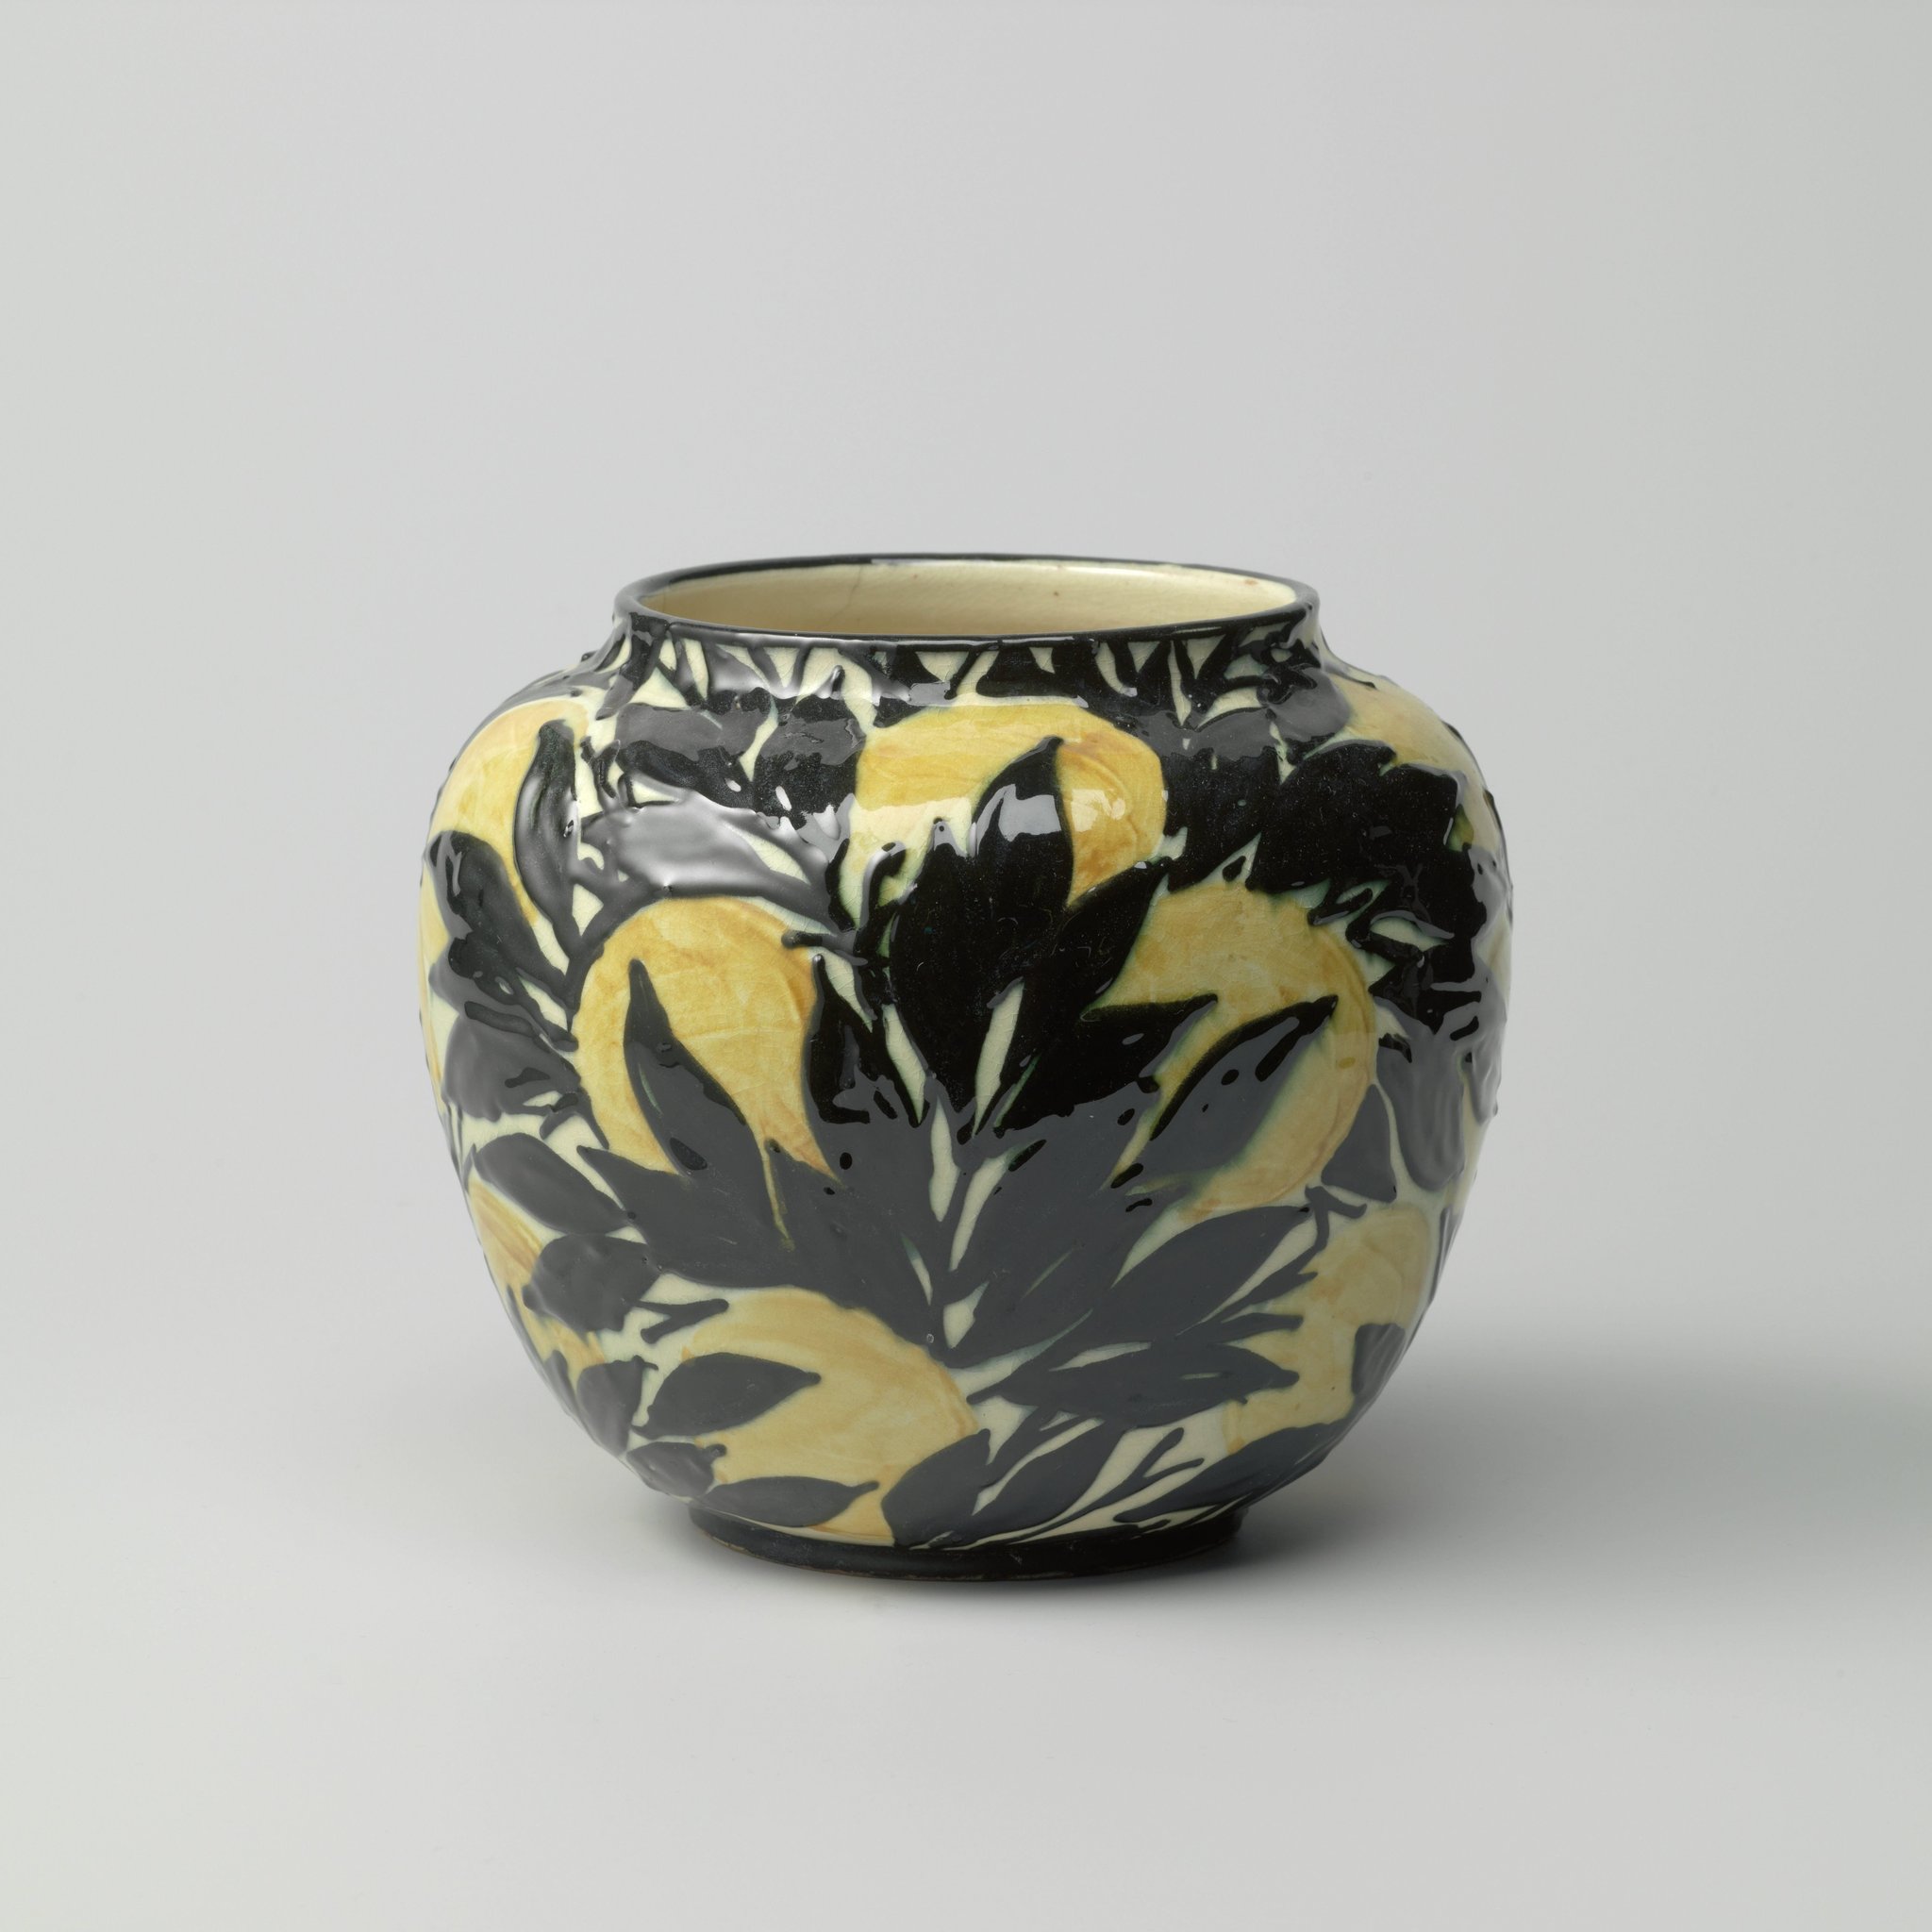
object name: pot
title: Pot van aardewerk, versierd in reliëf met gele citroenen en zwarte bladeren op een geelwitte fond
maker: max laeuger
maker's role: ceramicist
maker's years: 1864-1952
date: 1921-1925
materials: earthenware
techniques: slip technique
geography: karlsruhe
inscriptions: inscription: ‘18 03 // Prof. Läuger // Baden // DL HV’, factory mark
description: Pot van aardewerk, bol van vorm, versierd in reliëf, in slibtechniek, met gele citroenen en zwarte bladeren op geelwitte fond.